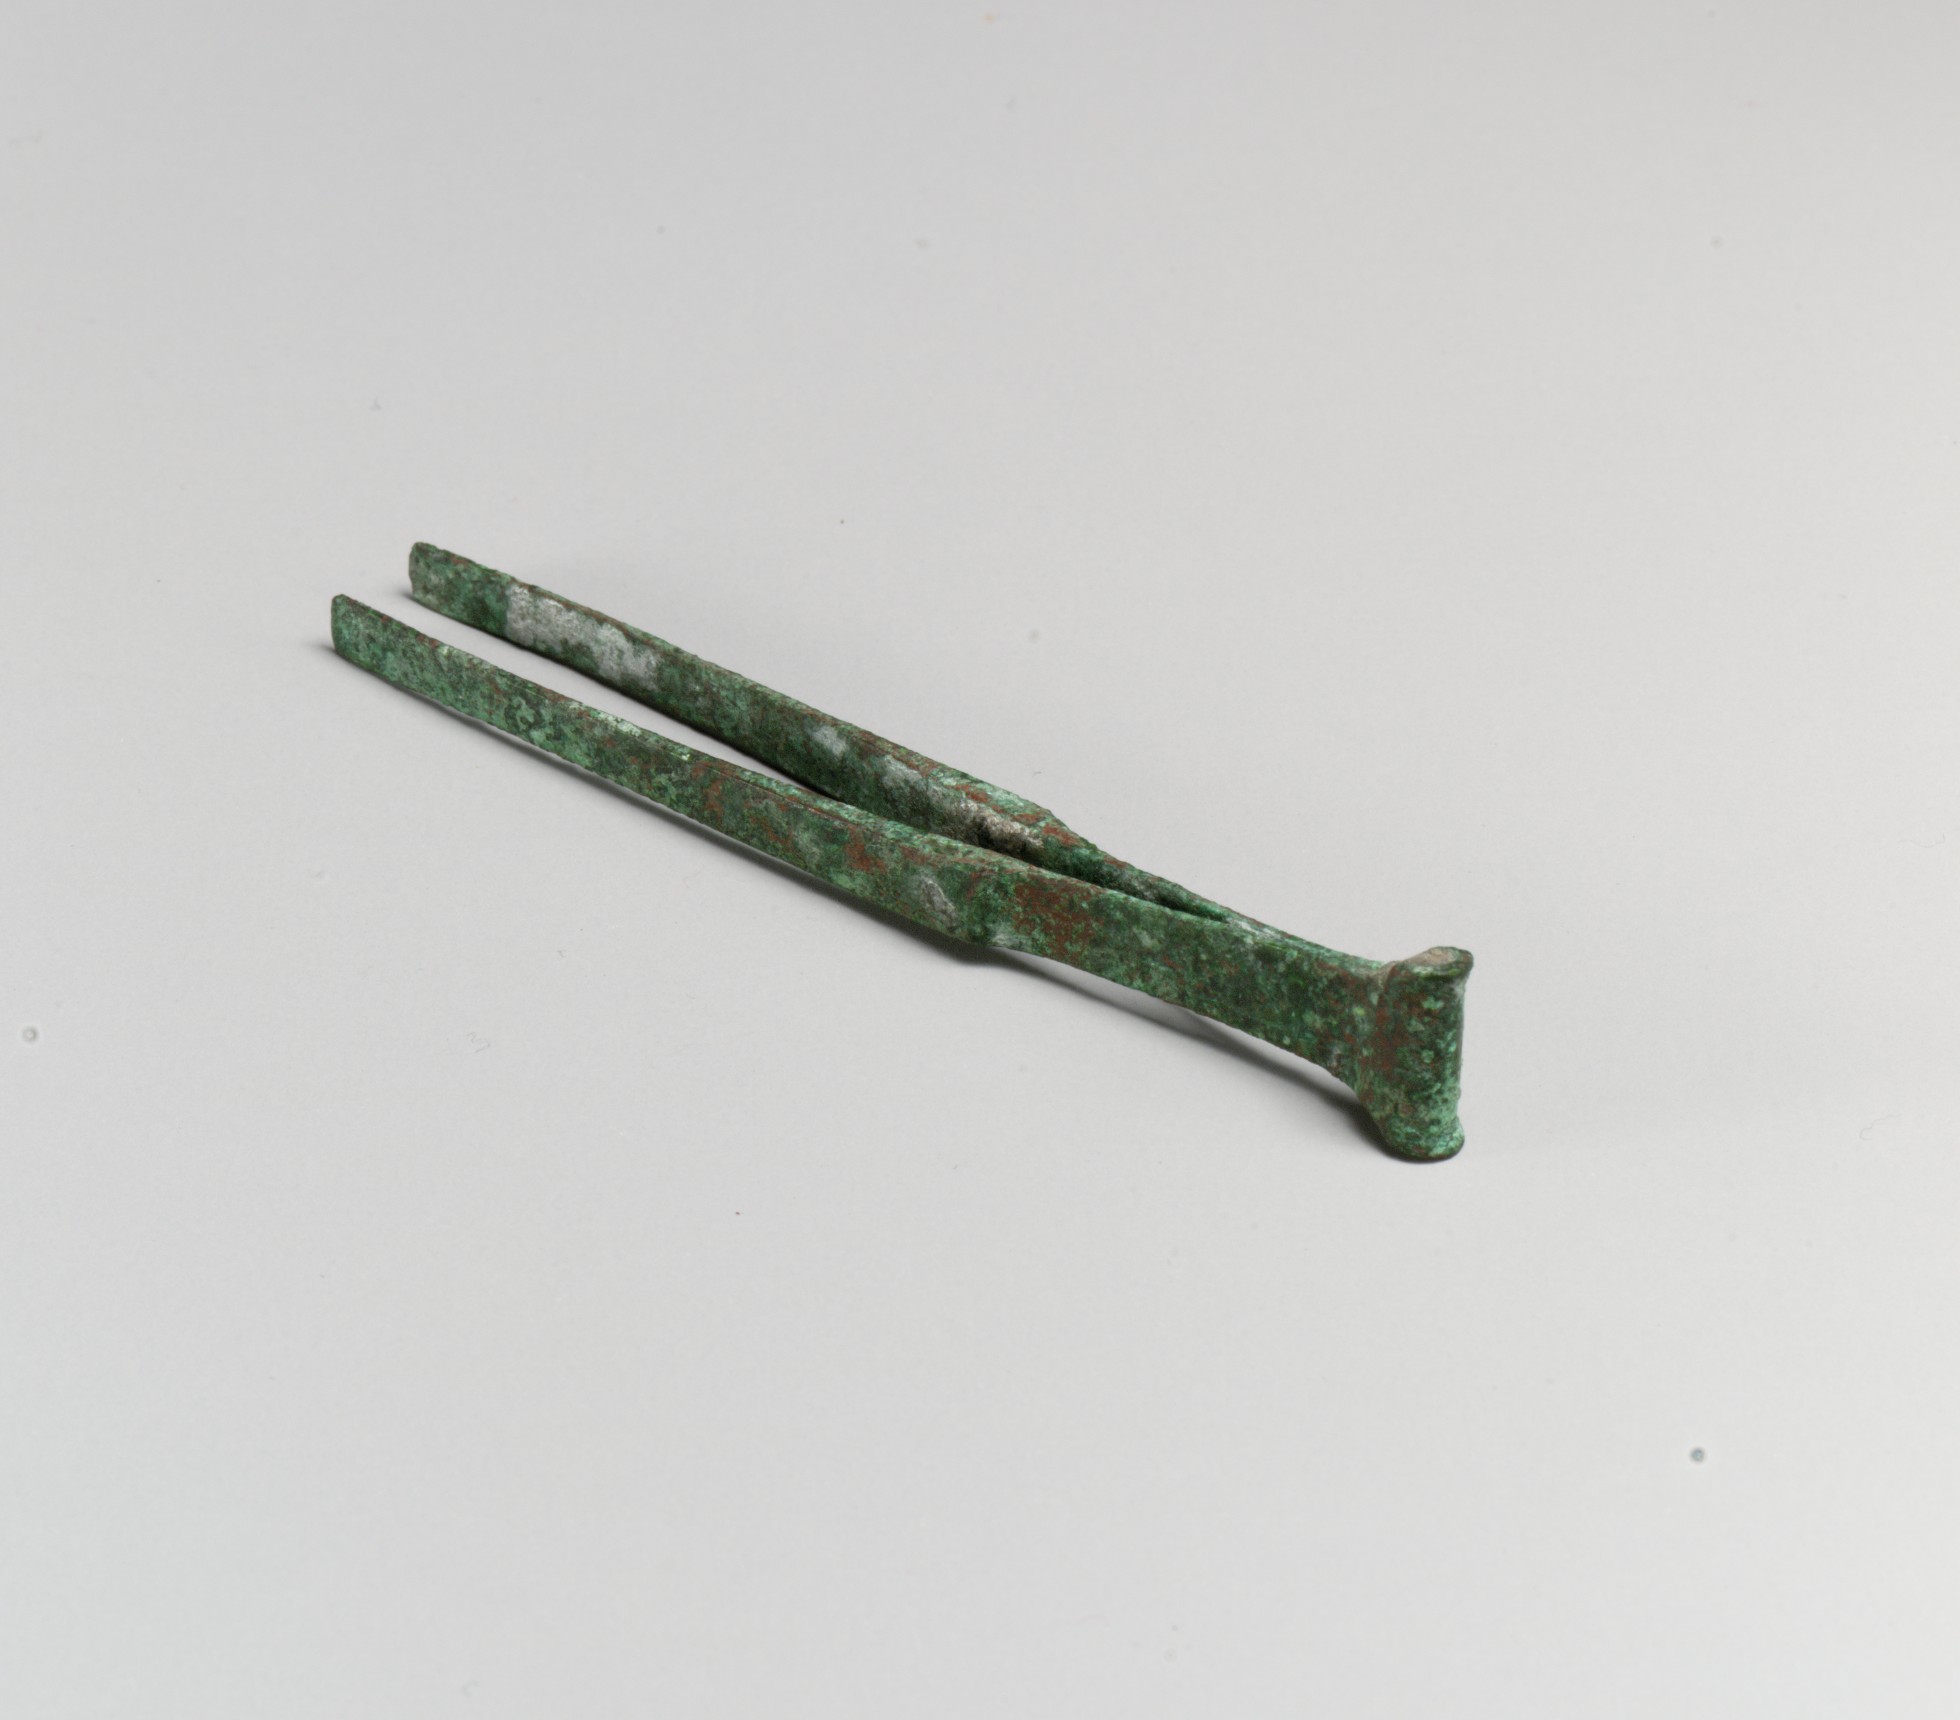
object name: tweezer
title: Tweezers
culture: roman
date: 670 BCE-330 CE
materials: bronze